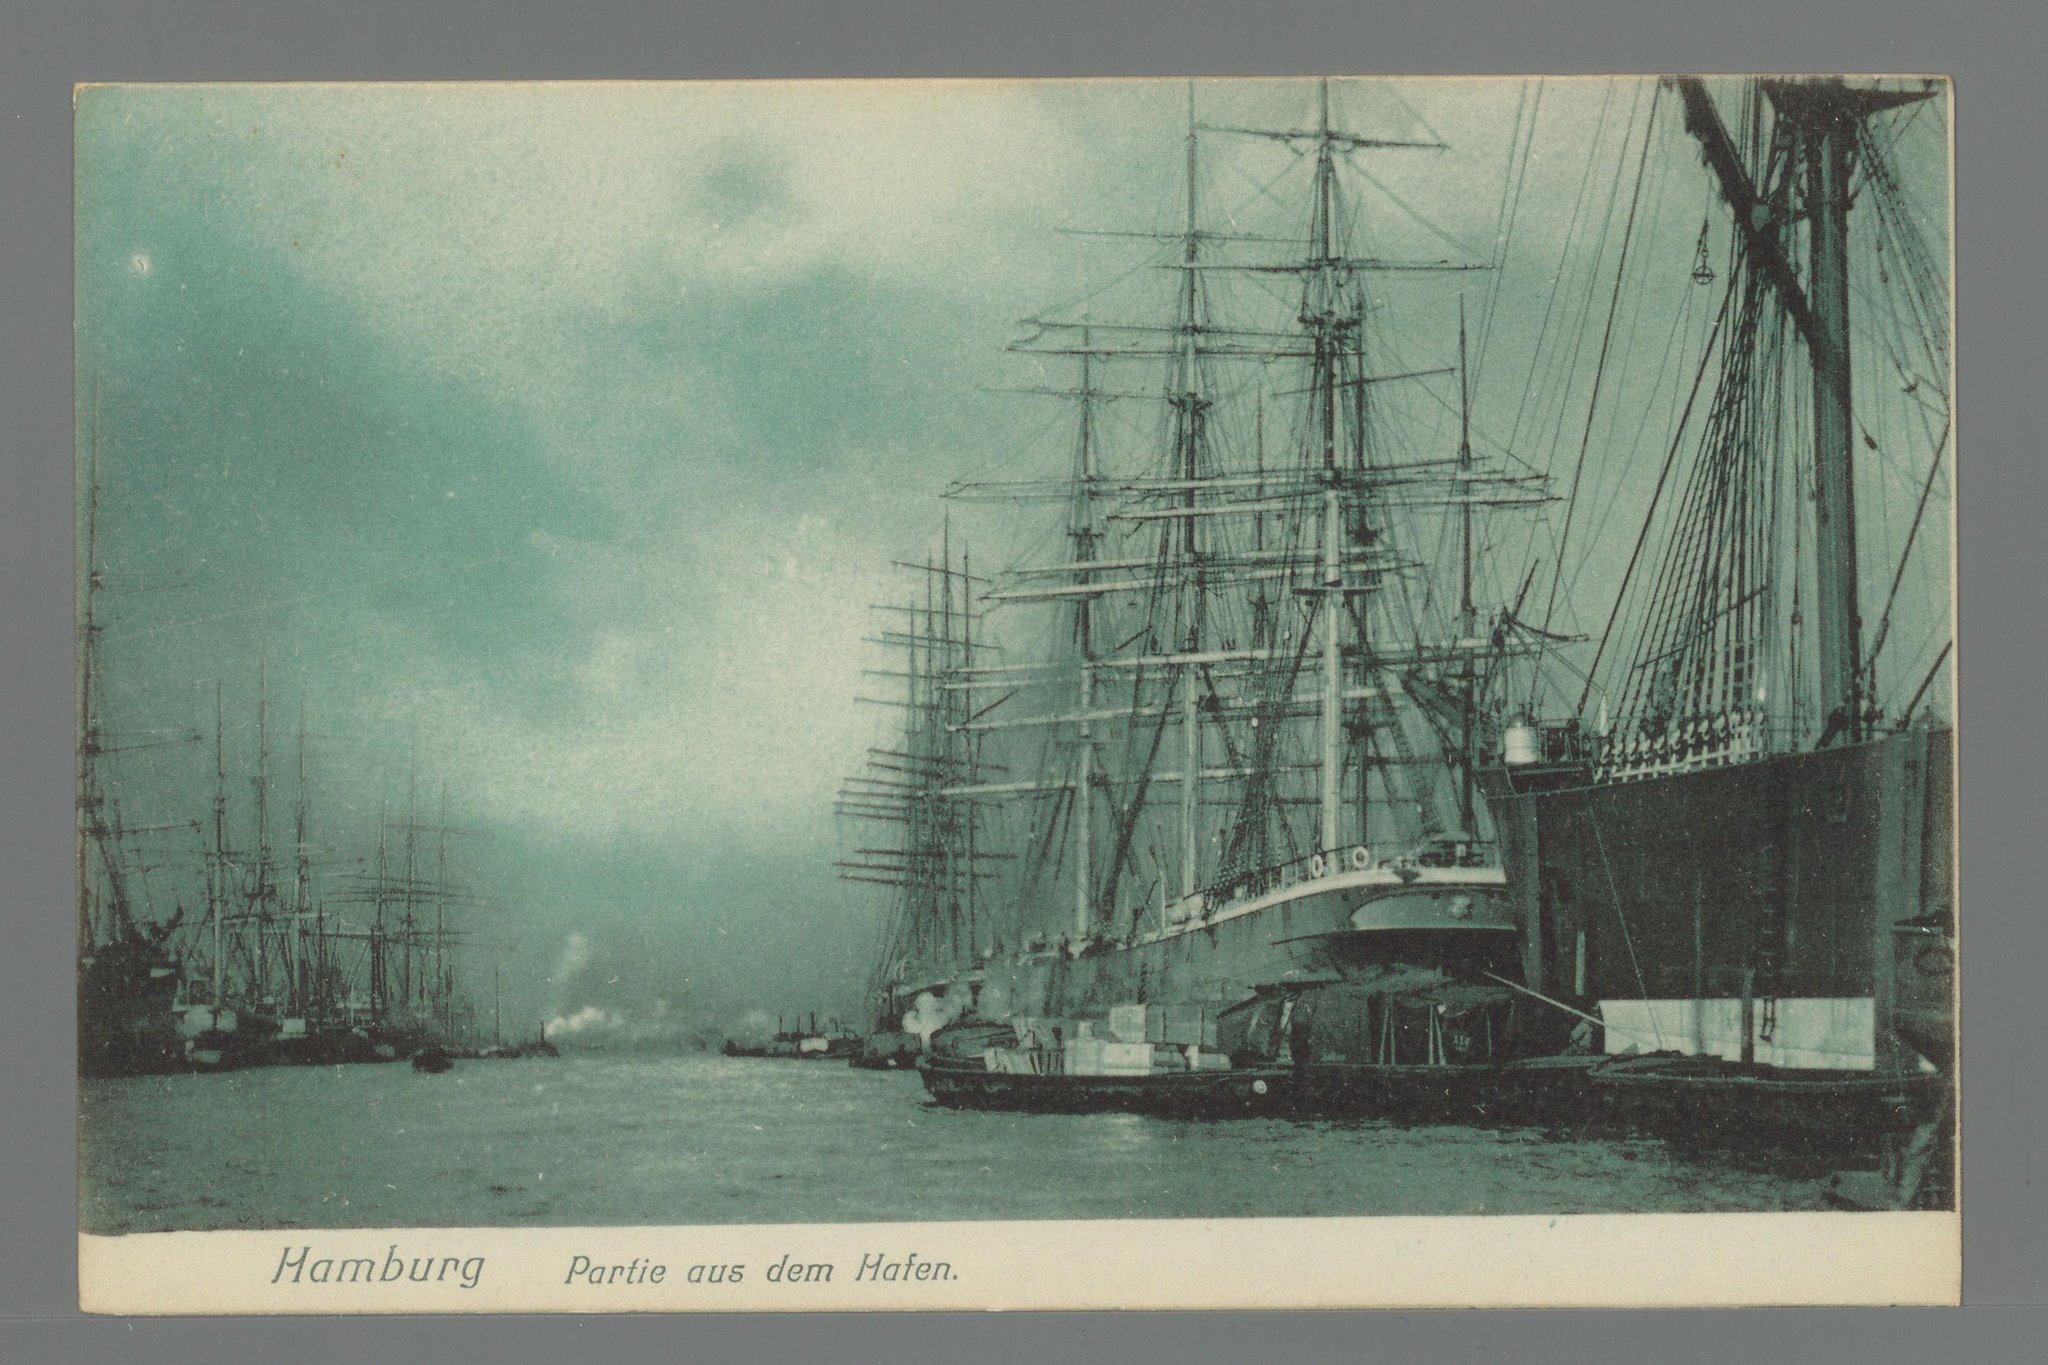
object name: photomechanical print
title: Luxusdruck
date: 1905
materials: cardboard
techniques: photograph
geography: hamburg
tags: harbour, ships (in general)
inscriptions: date